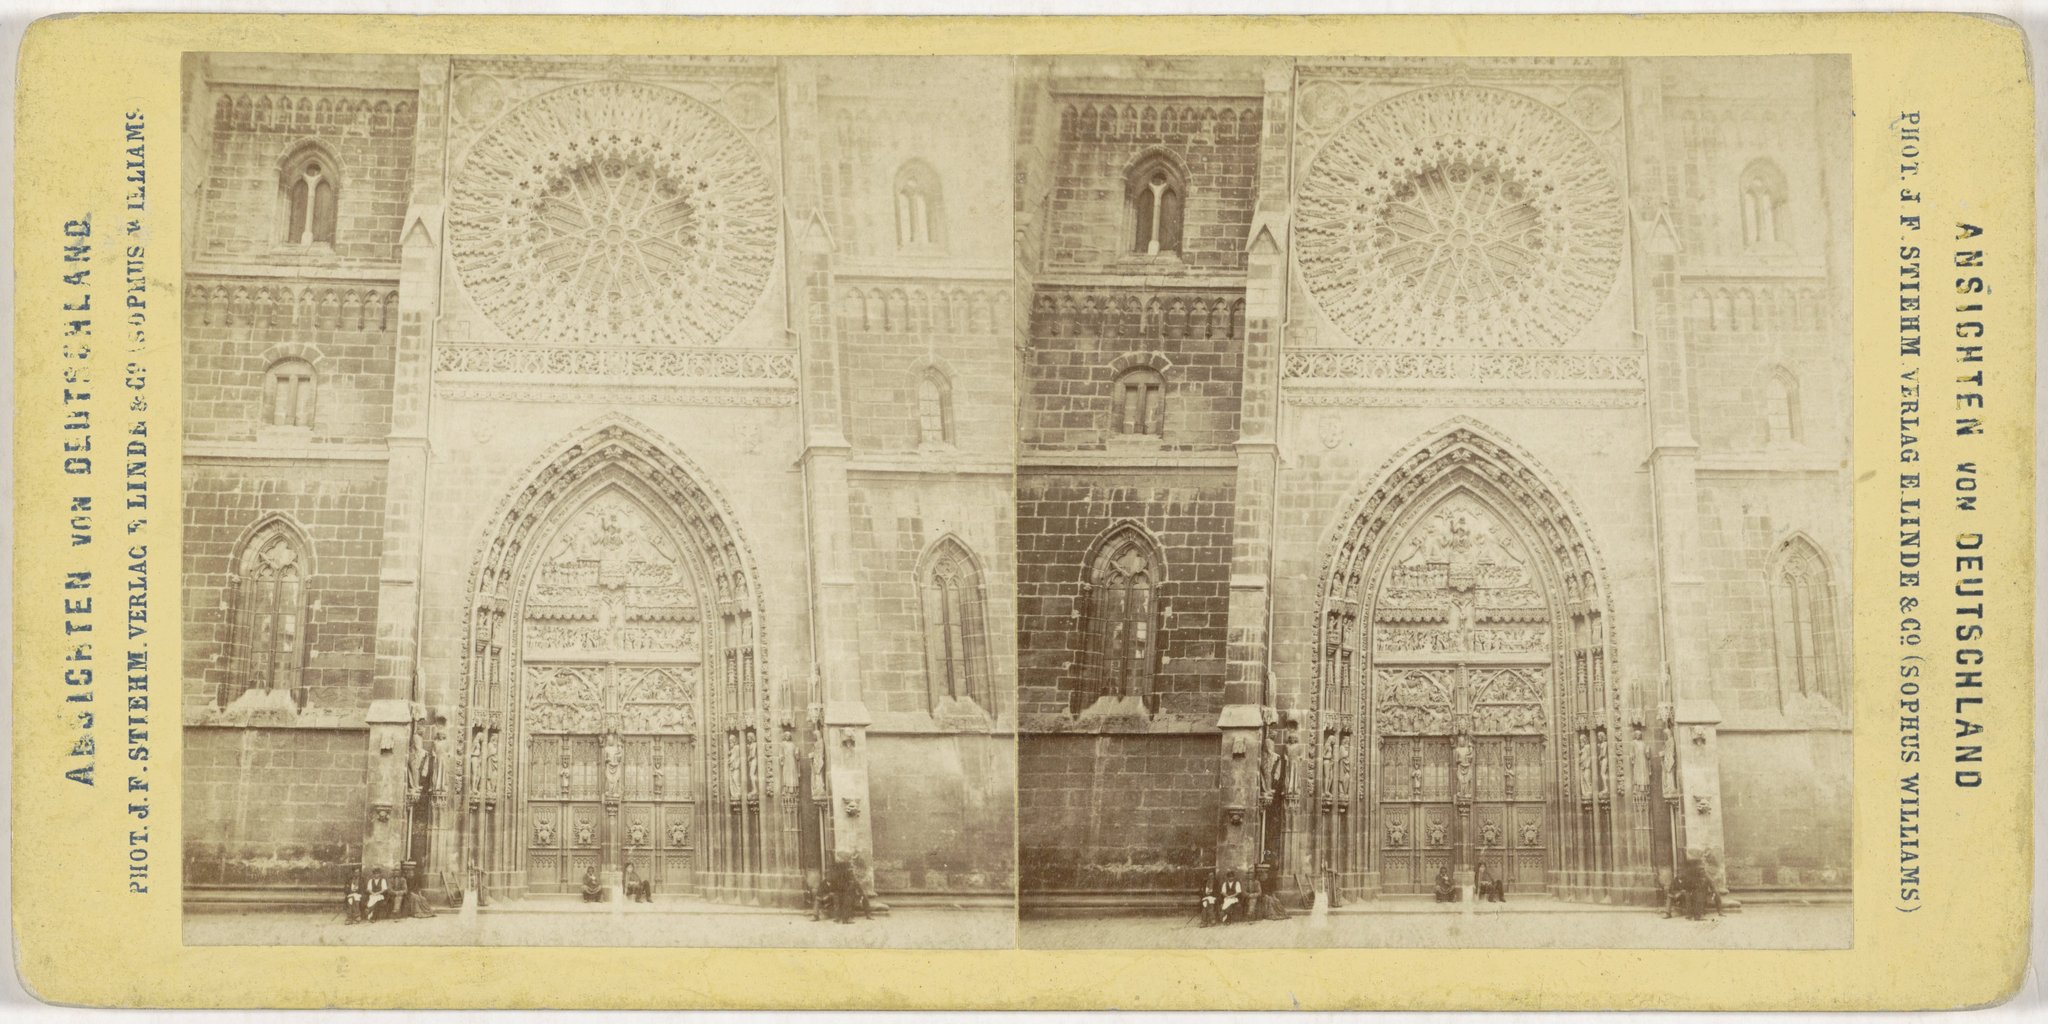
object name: stereograph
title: Deutschland - Nürnberg. Portal der Lorenz-Kirche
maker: johann friedrich stiehm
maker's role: fotograaf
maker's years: 1826-1902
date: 1868-1900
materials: cardboard, paper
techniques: albumen print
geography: nuremberg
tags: parts of church exterior and annexes: portal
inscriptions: number: ‘No. 2.’